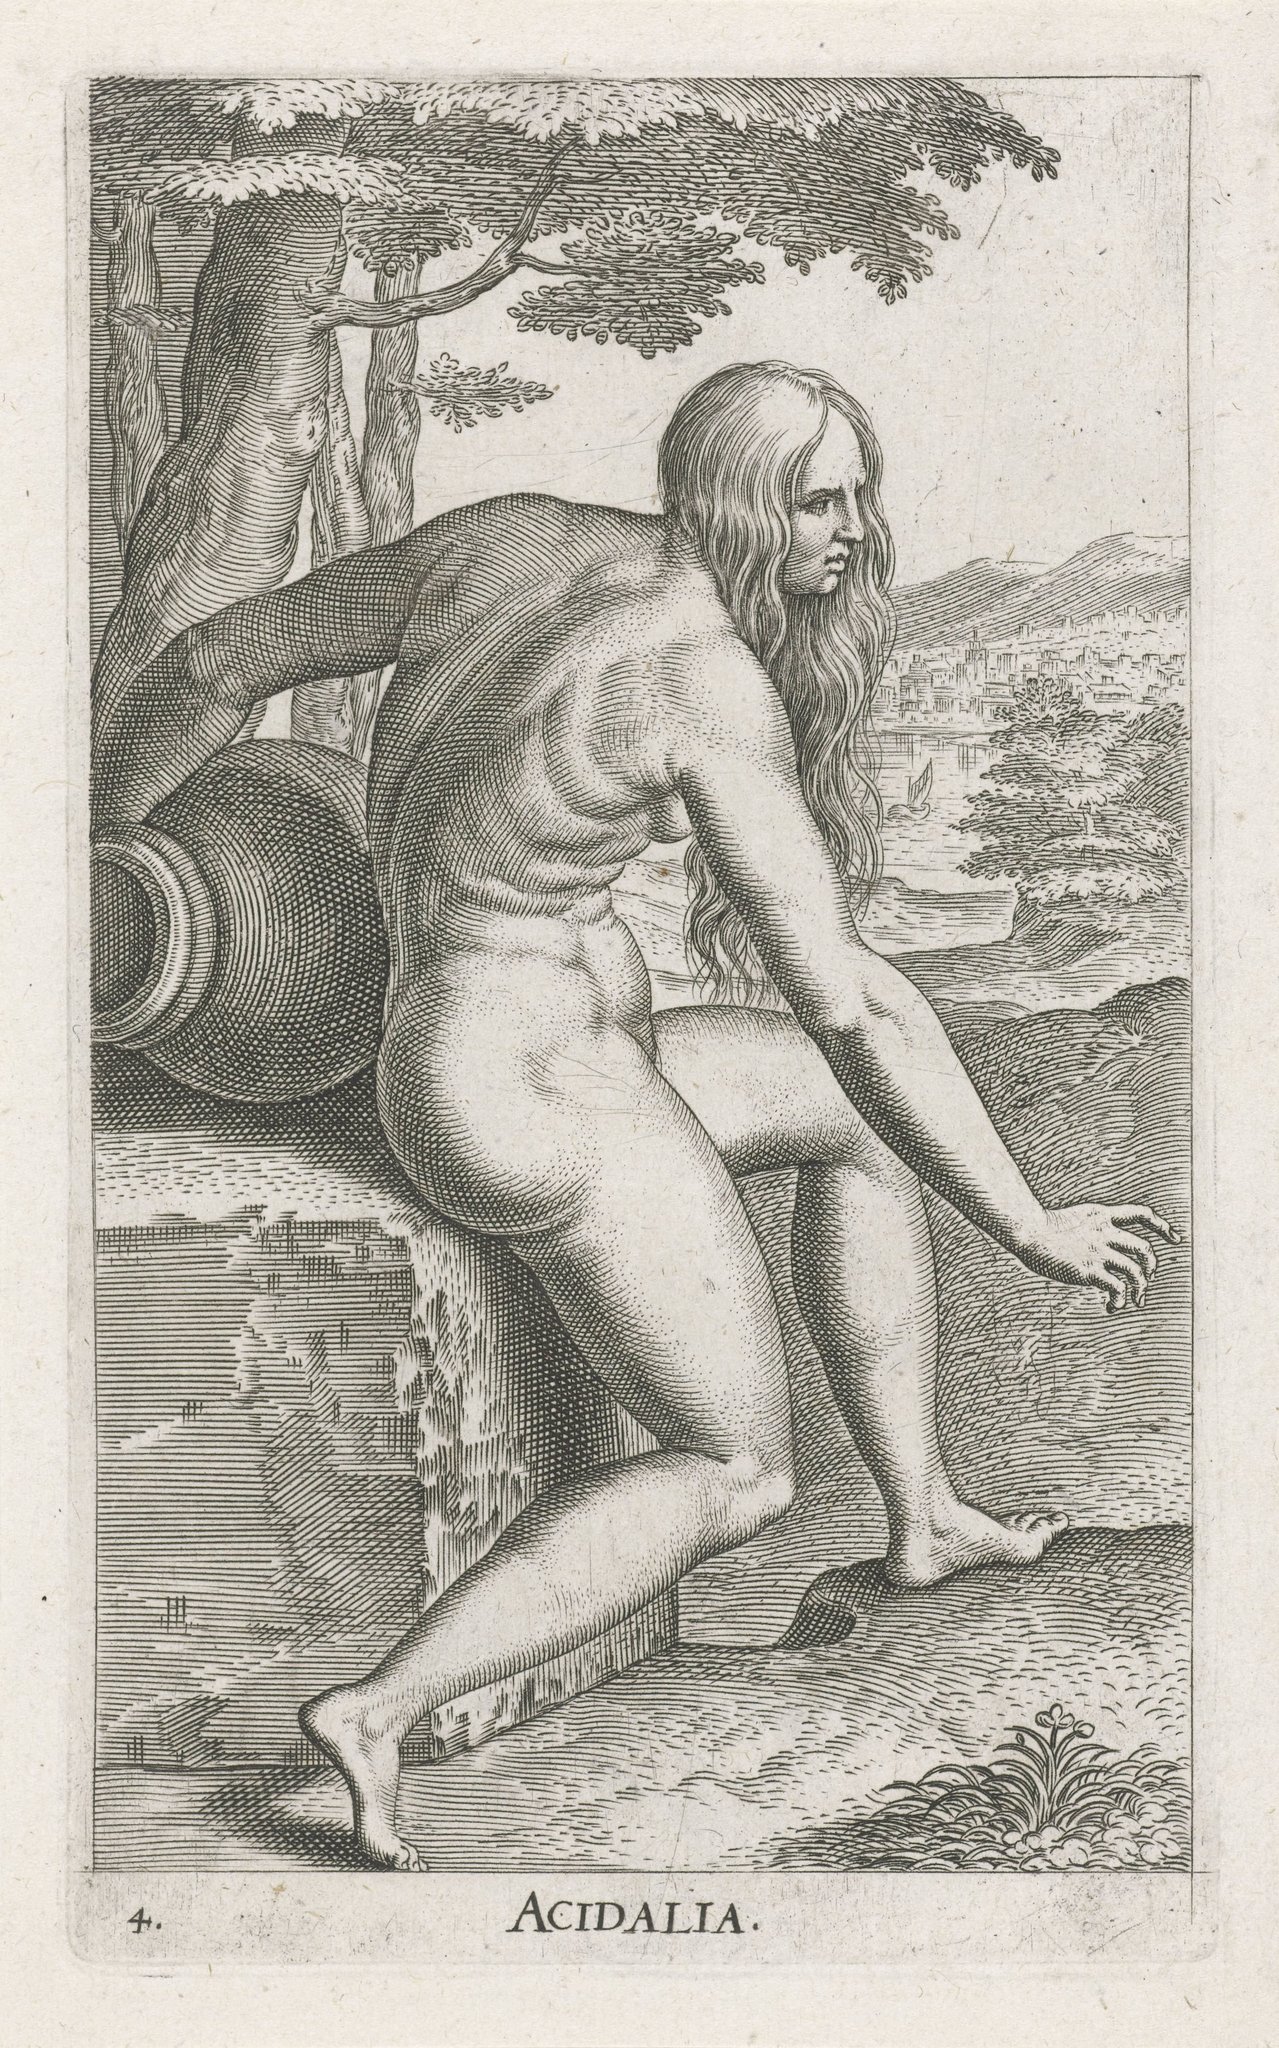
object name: print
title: Waternimf Venus Acidalia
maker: philips galle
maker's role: print maker, publisher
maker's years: 1537-1612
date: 1587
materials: paper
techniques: engraving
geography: antwerp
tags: other specific aspects of venus (with name)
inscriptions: collector's mark: Lugt 2228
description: De riviergodin Venus Acidalia, gezeten op een stenen blok. De prent maakt deel uit van een zeventiendelige serie over stroom- en waternimfen.